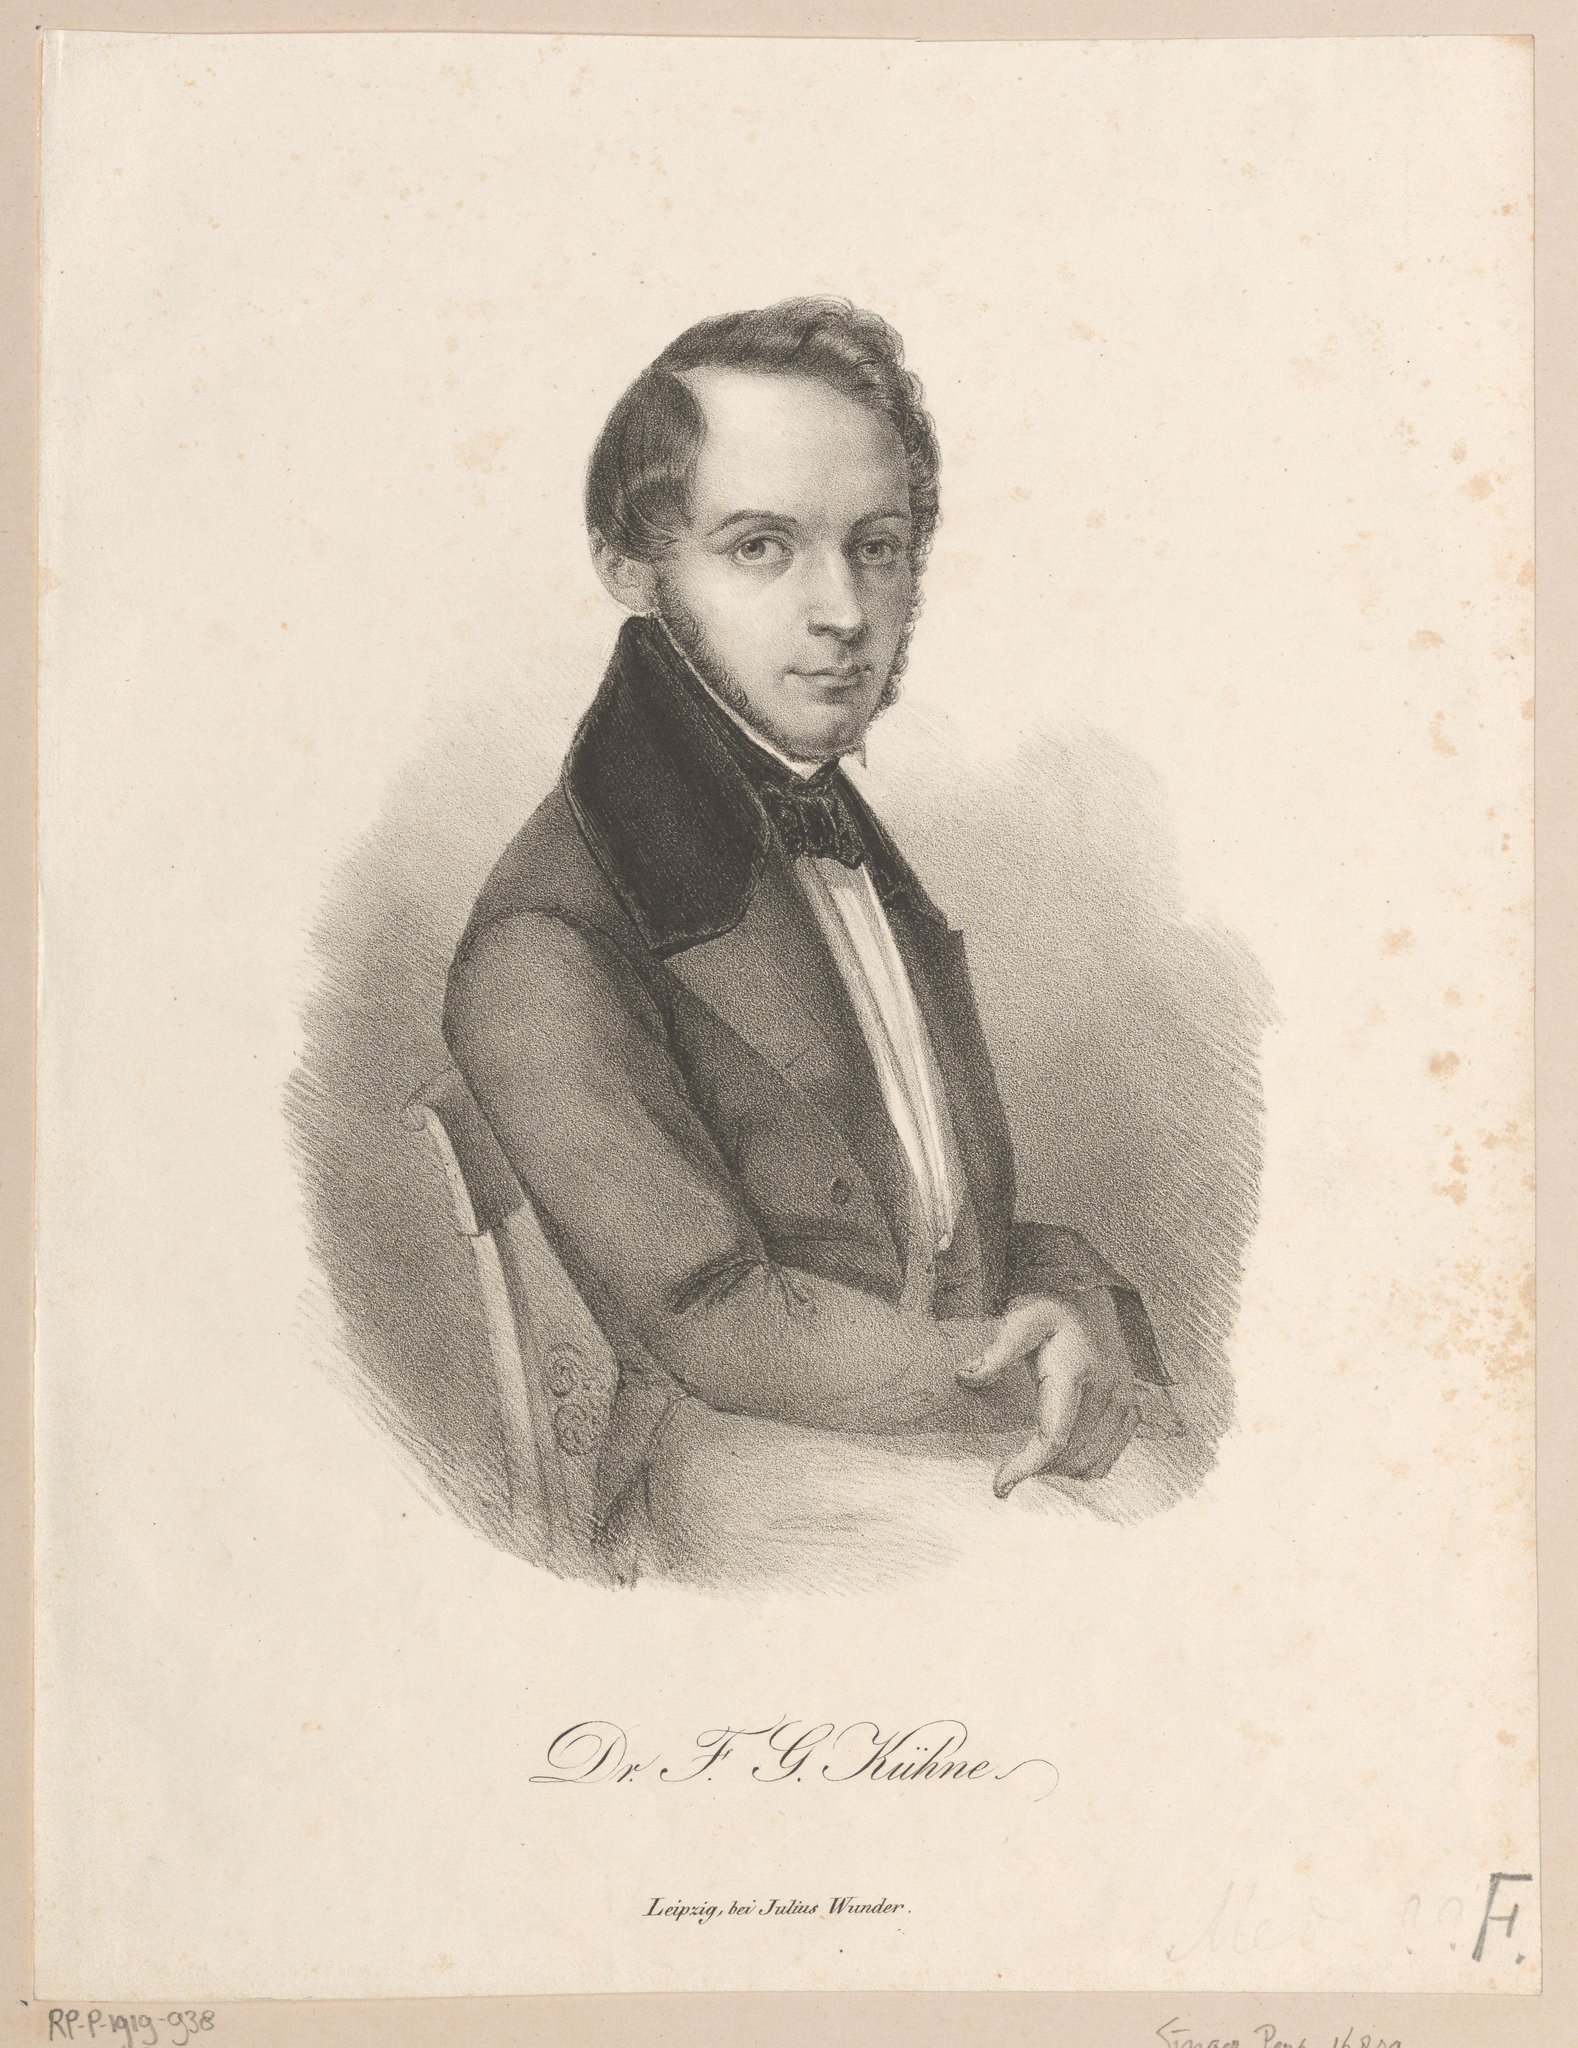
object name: print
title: Portret van Gustav Kühne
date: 1821-1899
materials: paper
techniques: lithograph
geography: leipzig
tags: historical persons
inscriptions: collector's mark: Lugt 2228